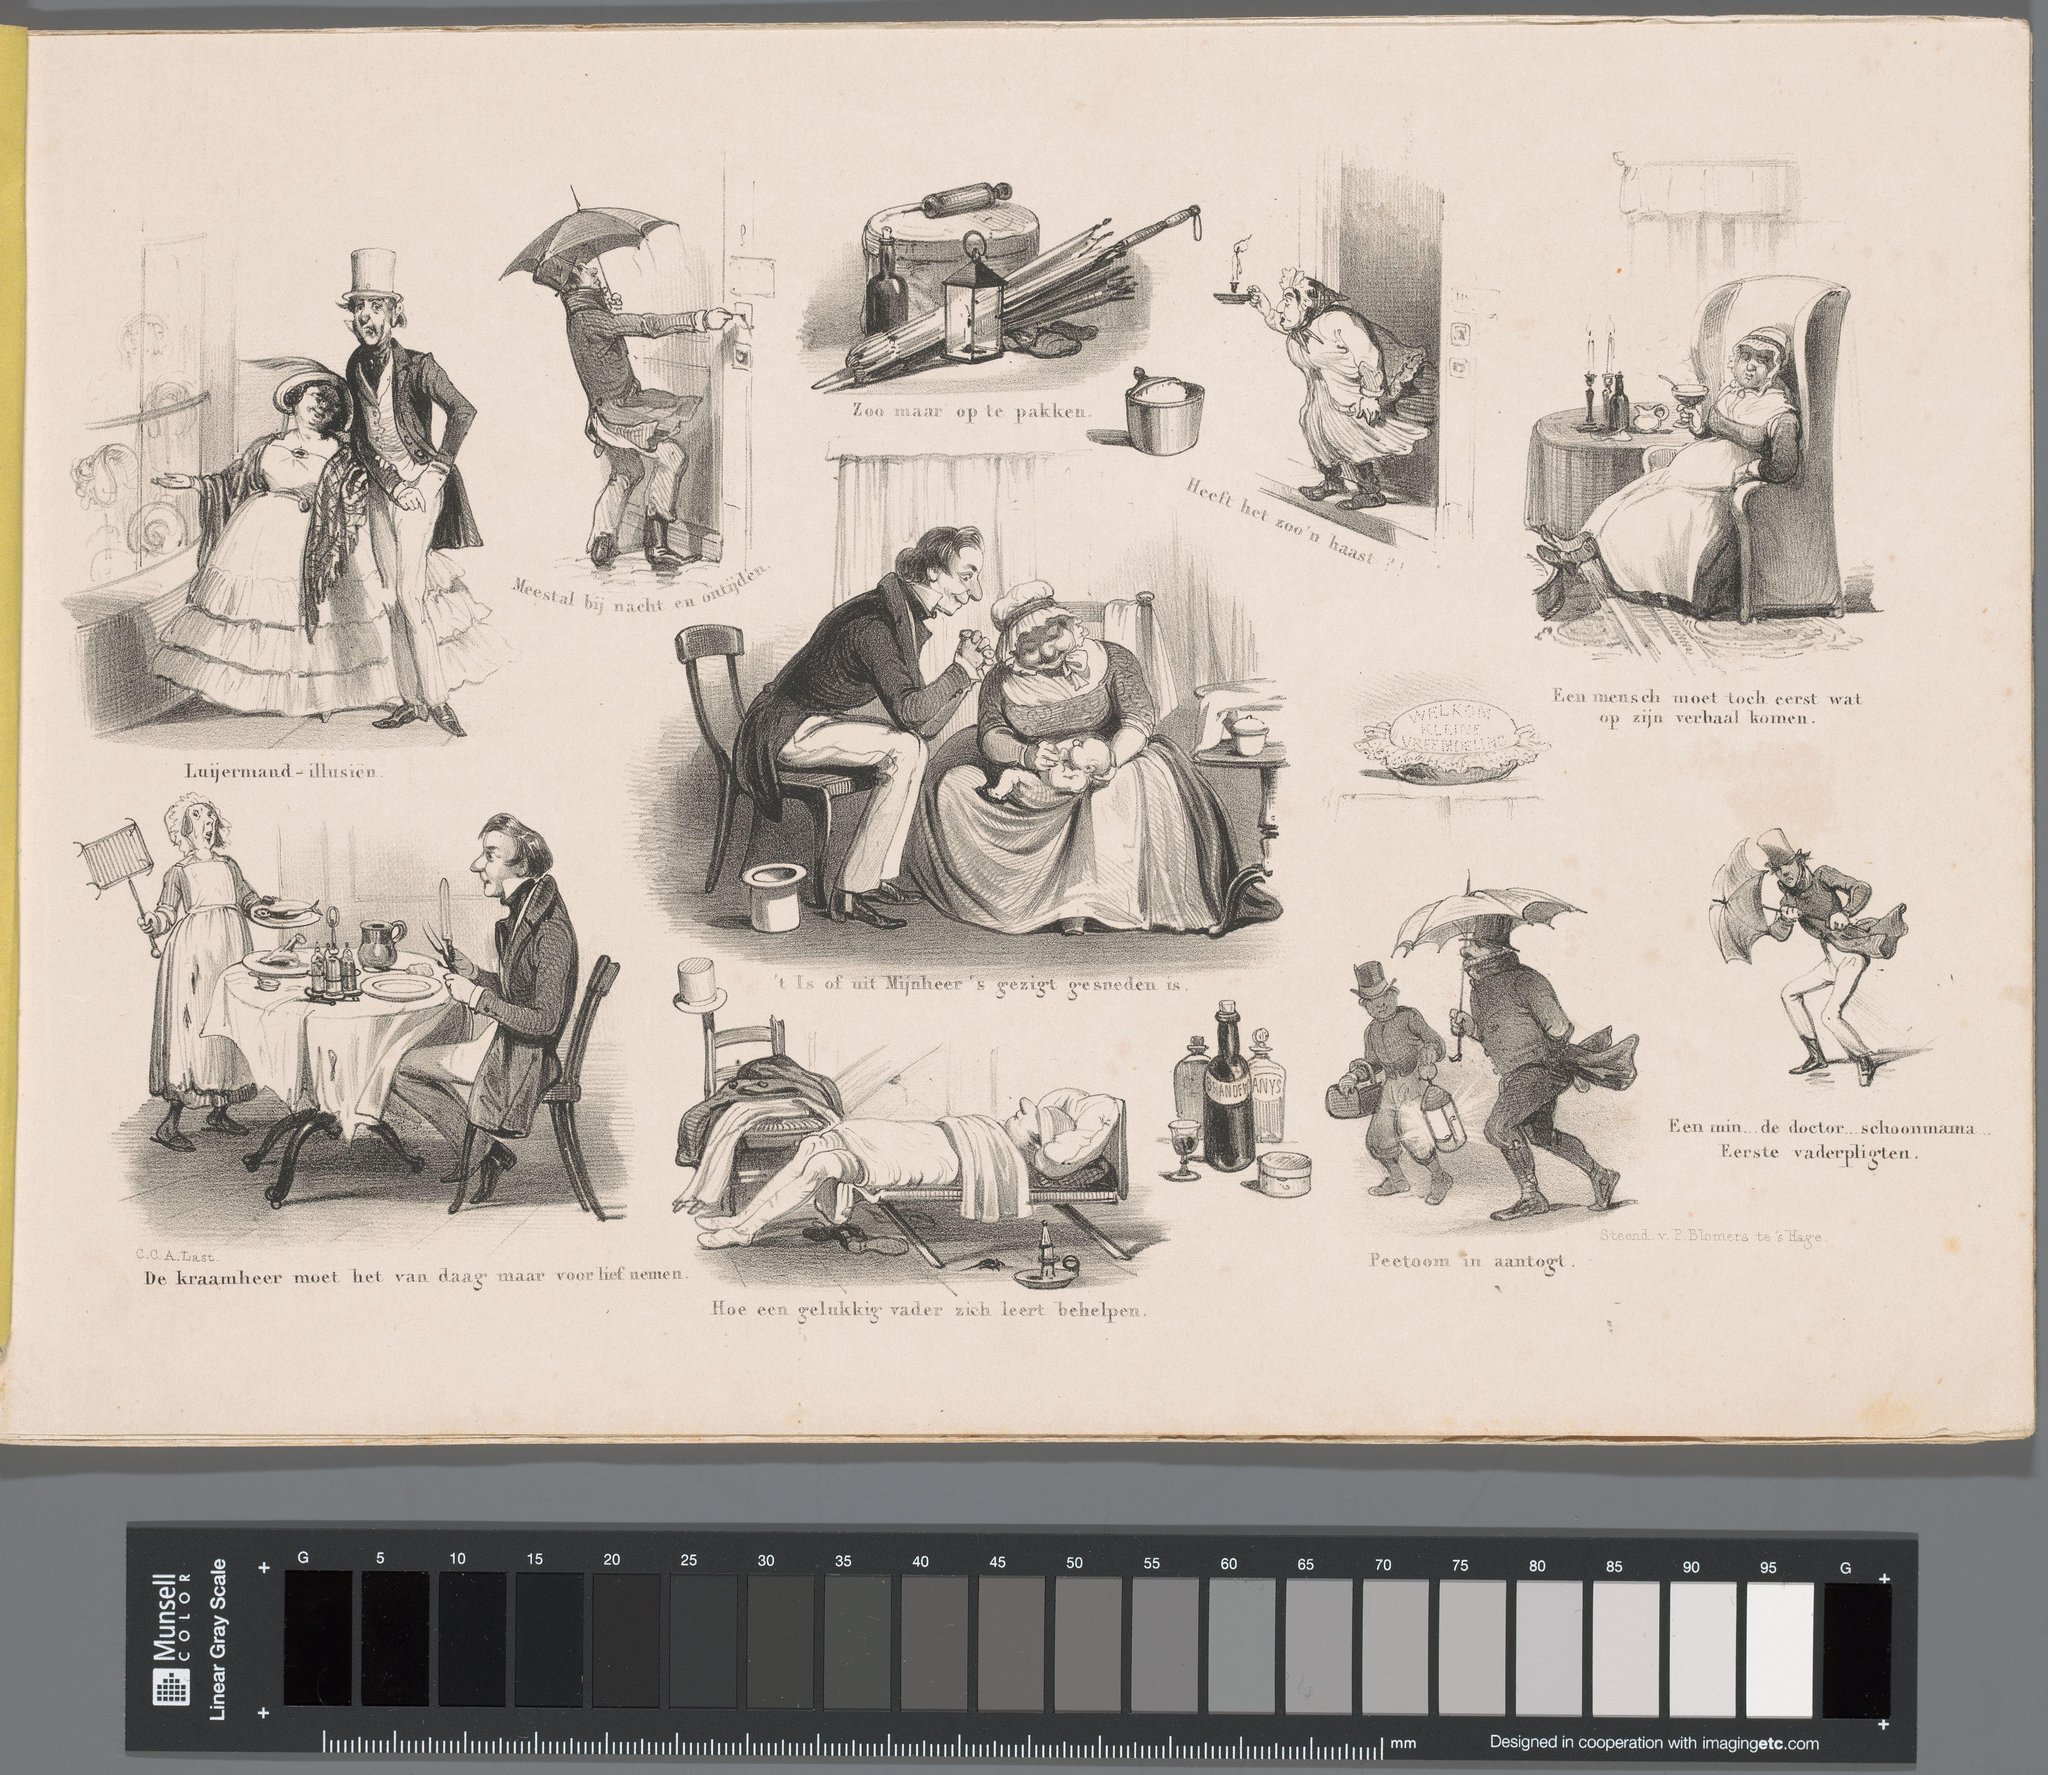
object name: print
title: Taferelen uit het leven van een jonge vader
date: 1842-1887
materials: paper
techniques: lithograph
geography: the hague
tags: family life at home, infant, baby ~ the ages of man, father-love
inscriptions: collector's mark: Lugt 2760, collector's mark: Lugt 2228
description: In het midden kijkt de vader vol bewondering naar zijn baby. Daaromheen scènes uit het dagelijks leven met onderschrift. Deze prent is samengebonden met vijf andere prenten uit dezelfde serie en een titelblad.